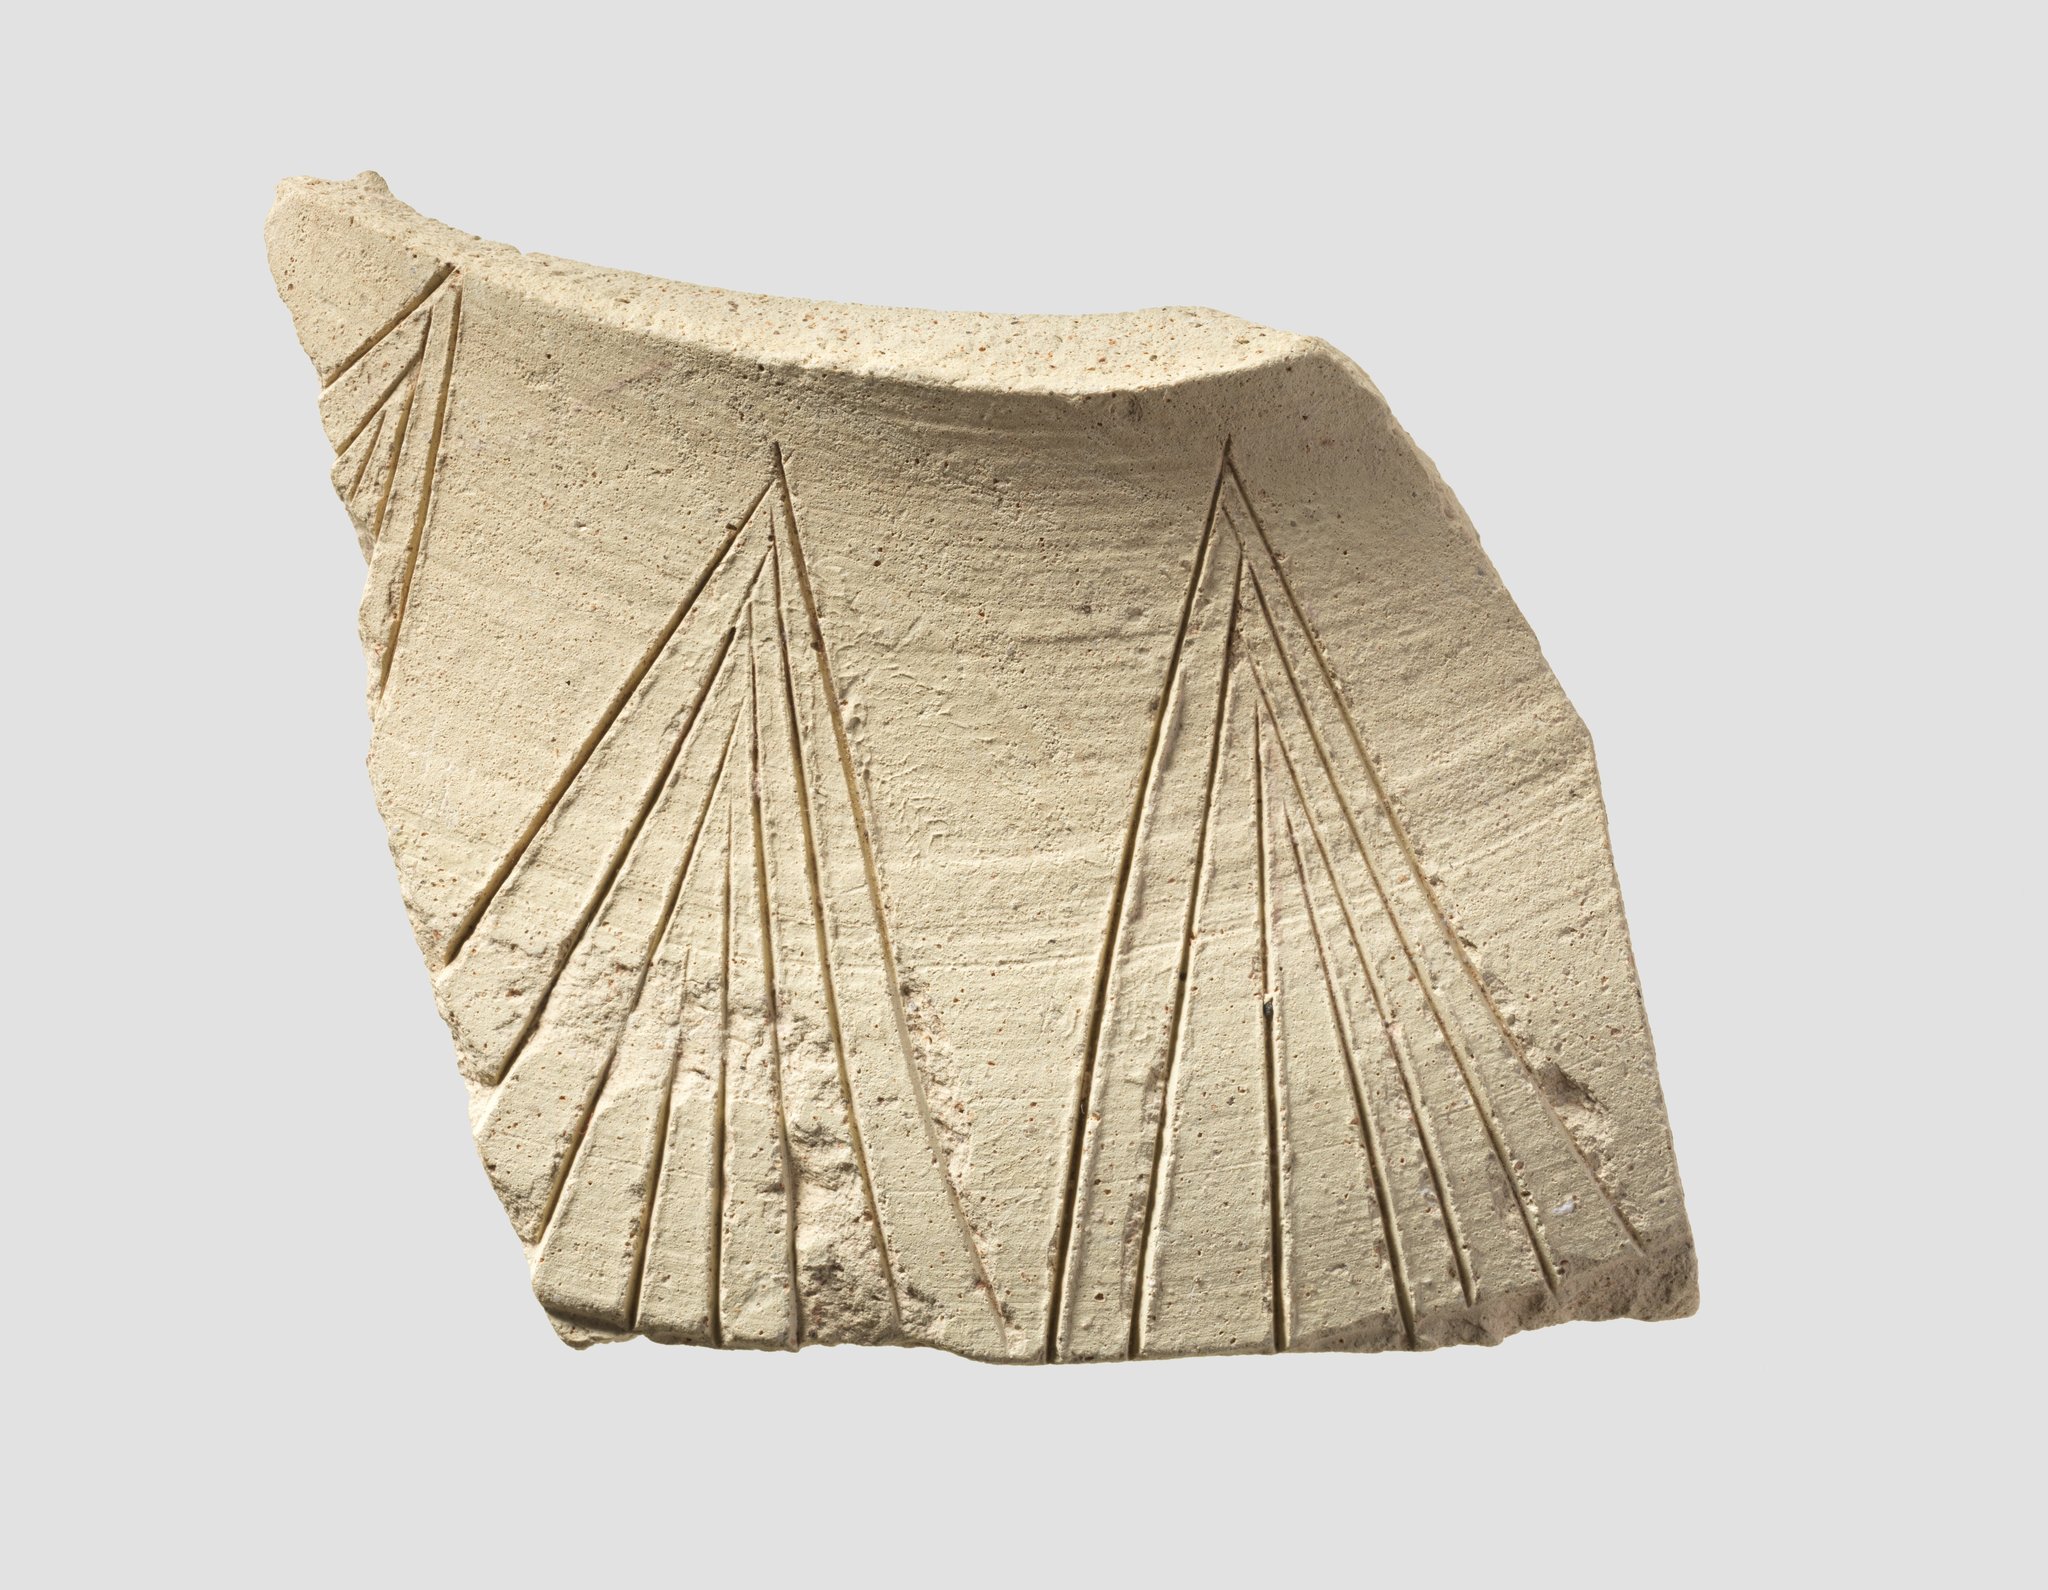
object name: sherd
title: Sherd with incised decoration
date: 2333-2001 BCE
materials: ceramic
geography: mesopotamia